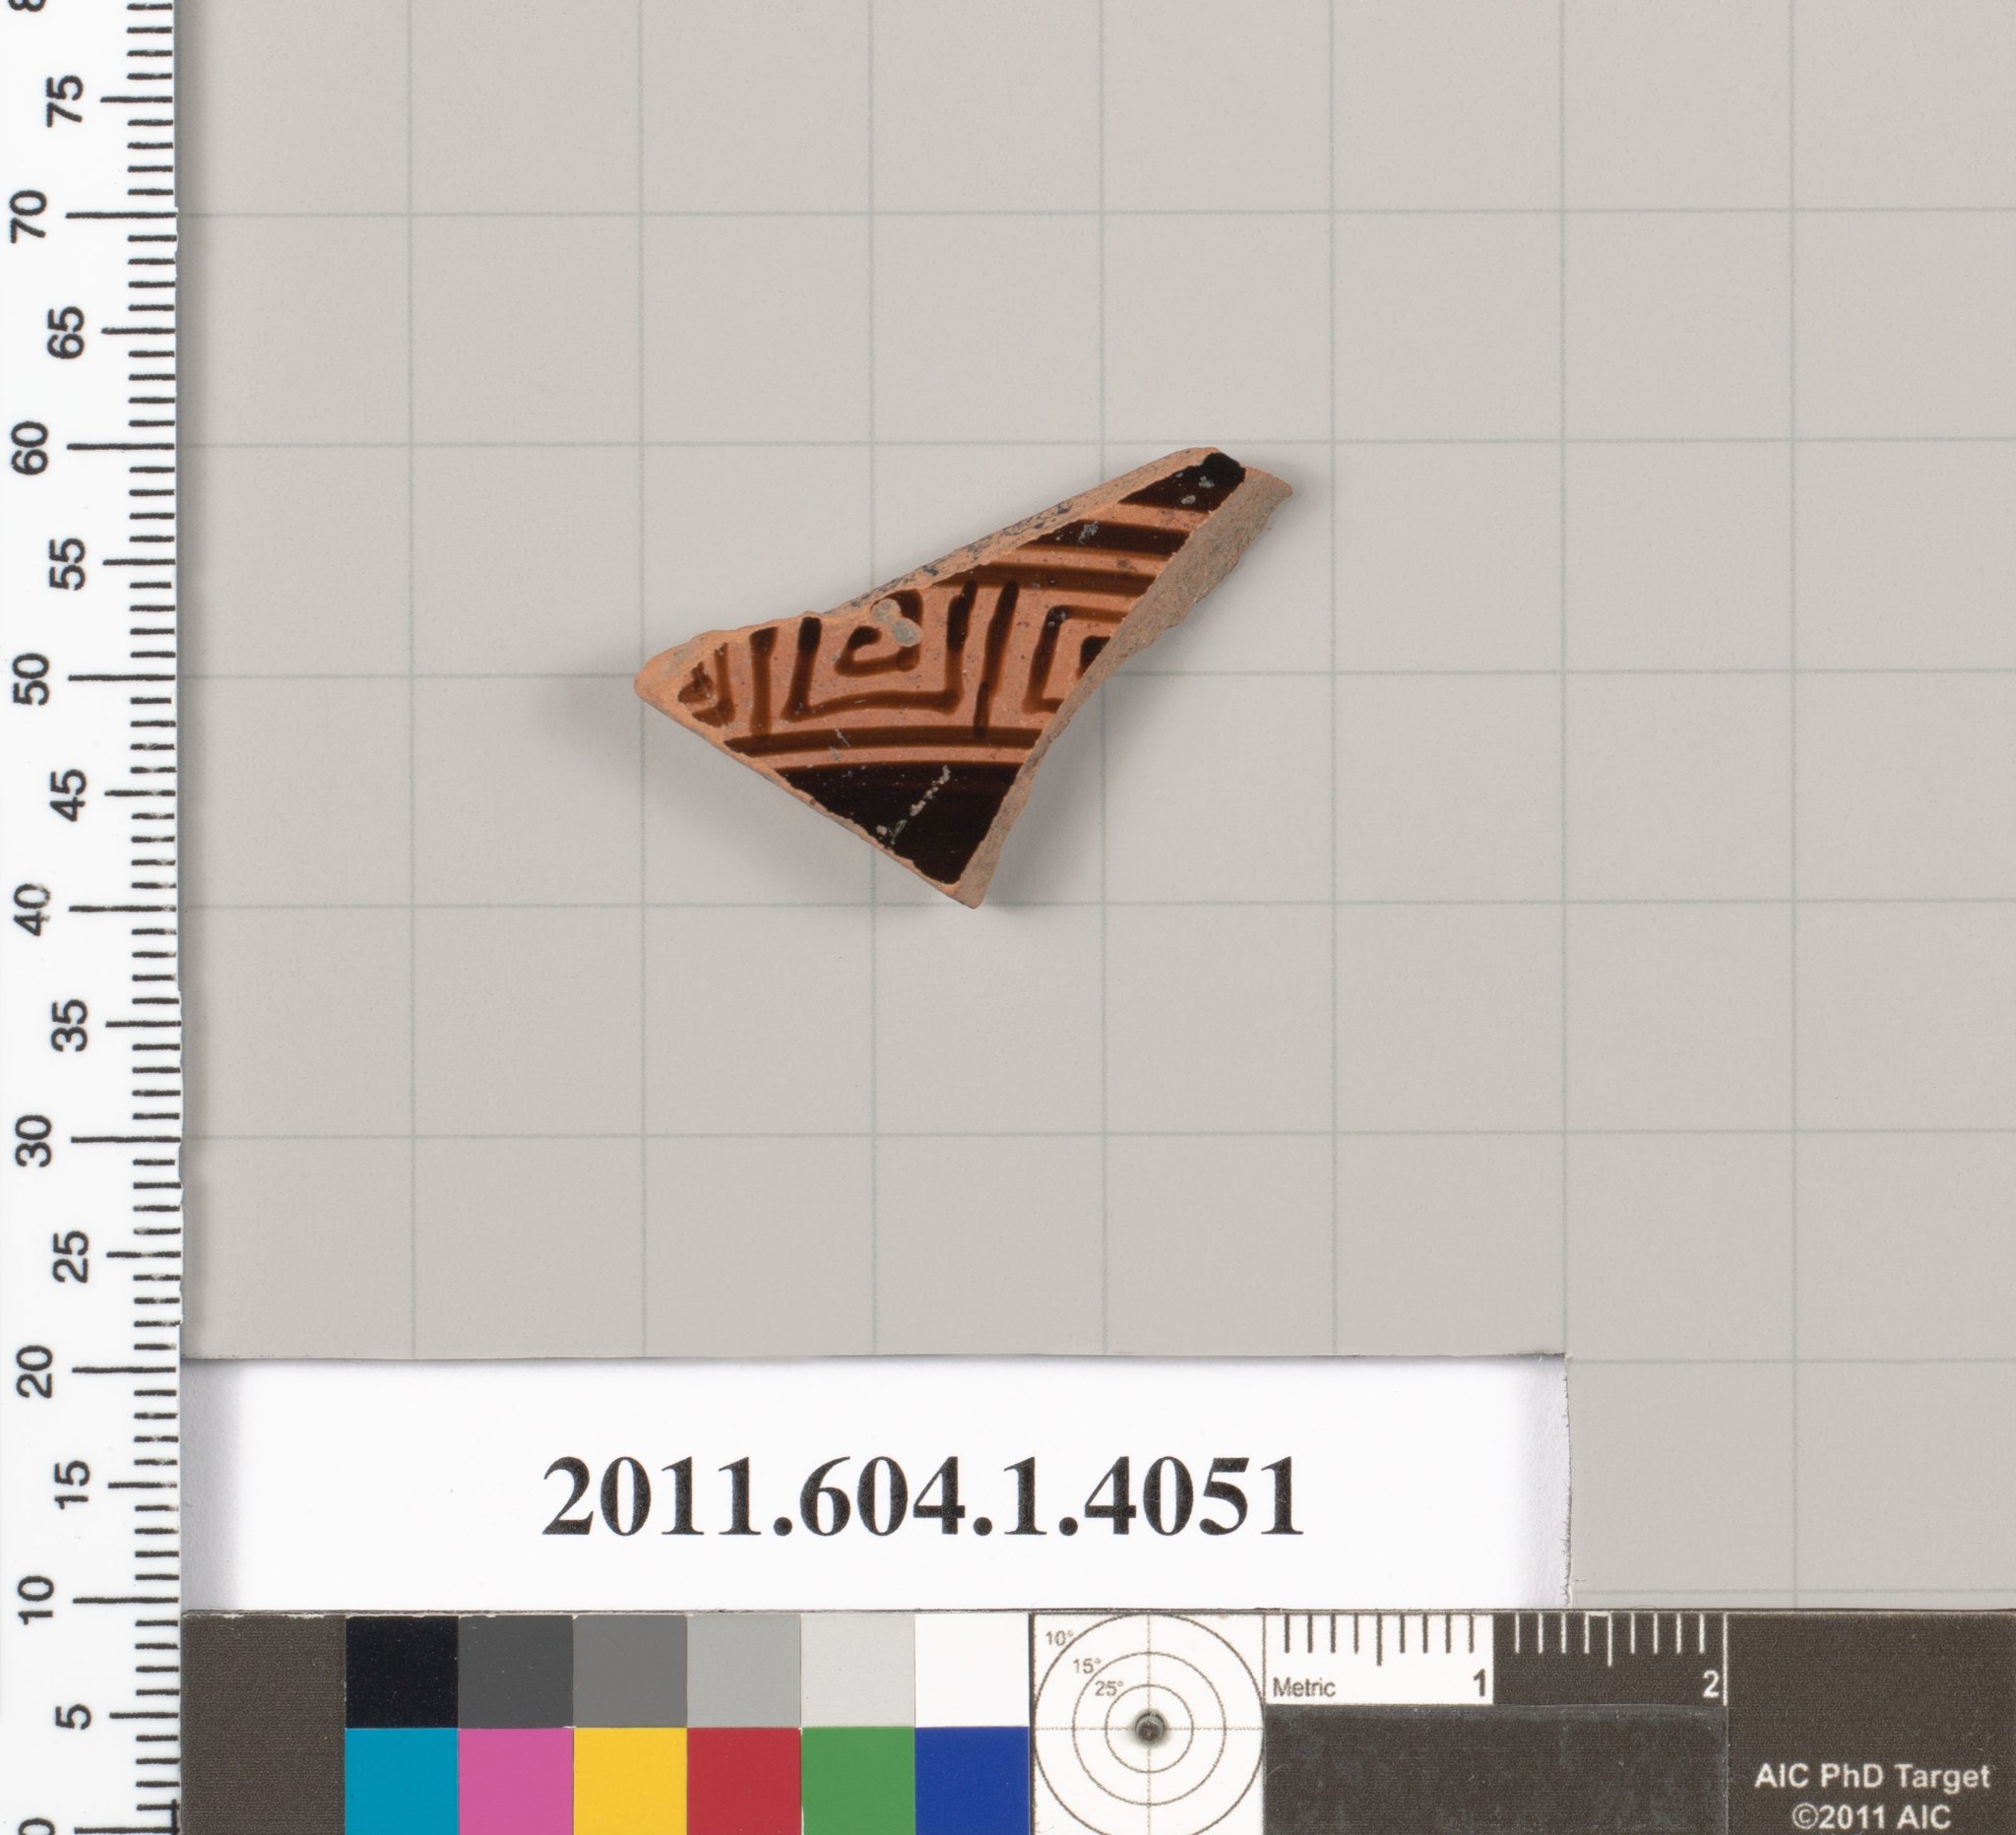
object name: kylix fragment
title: Terracotta fragment of a kylix (drinking cup)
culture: greek, attic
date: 500-480 BCE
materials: terracotta